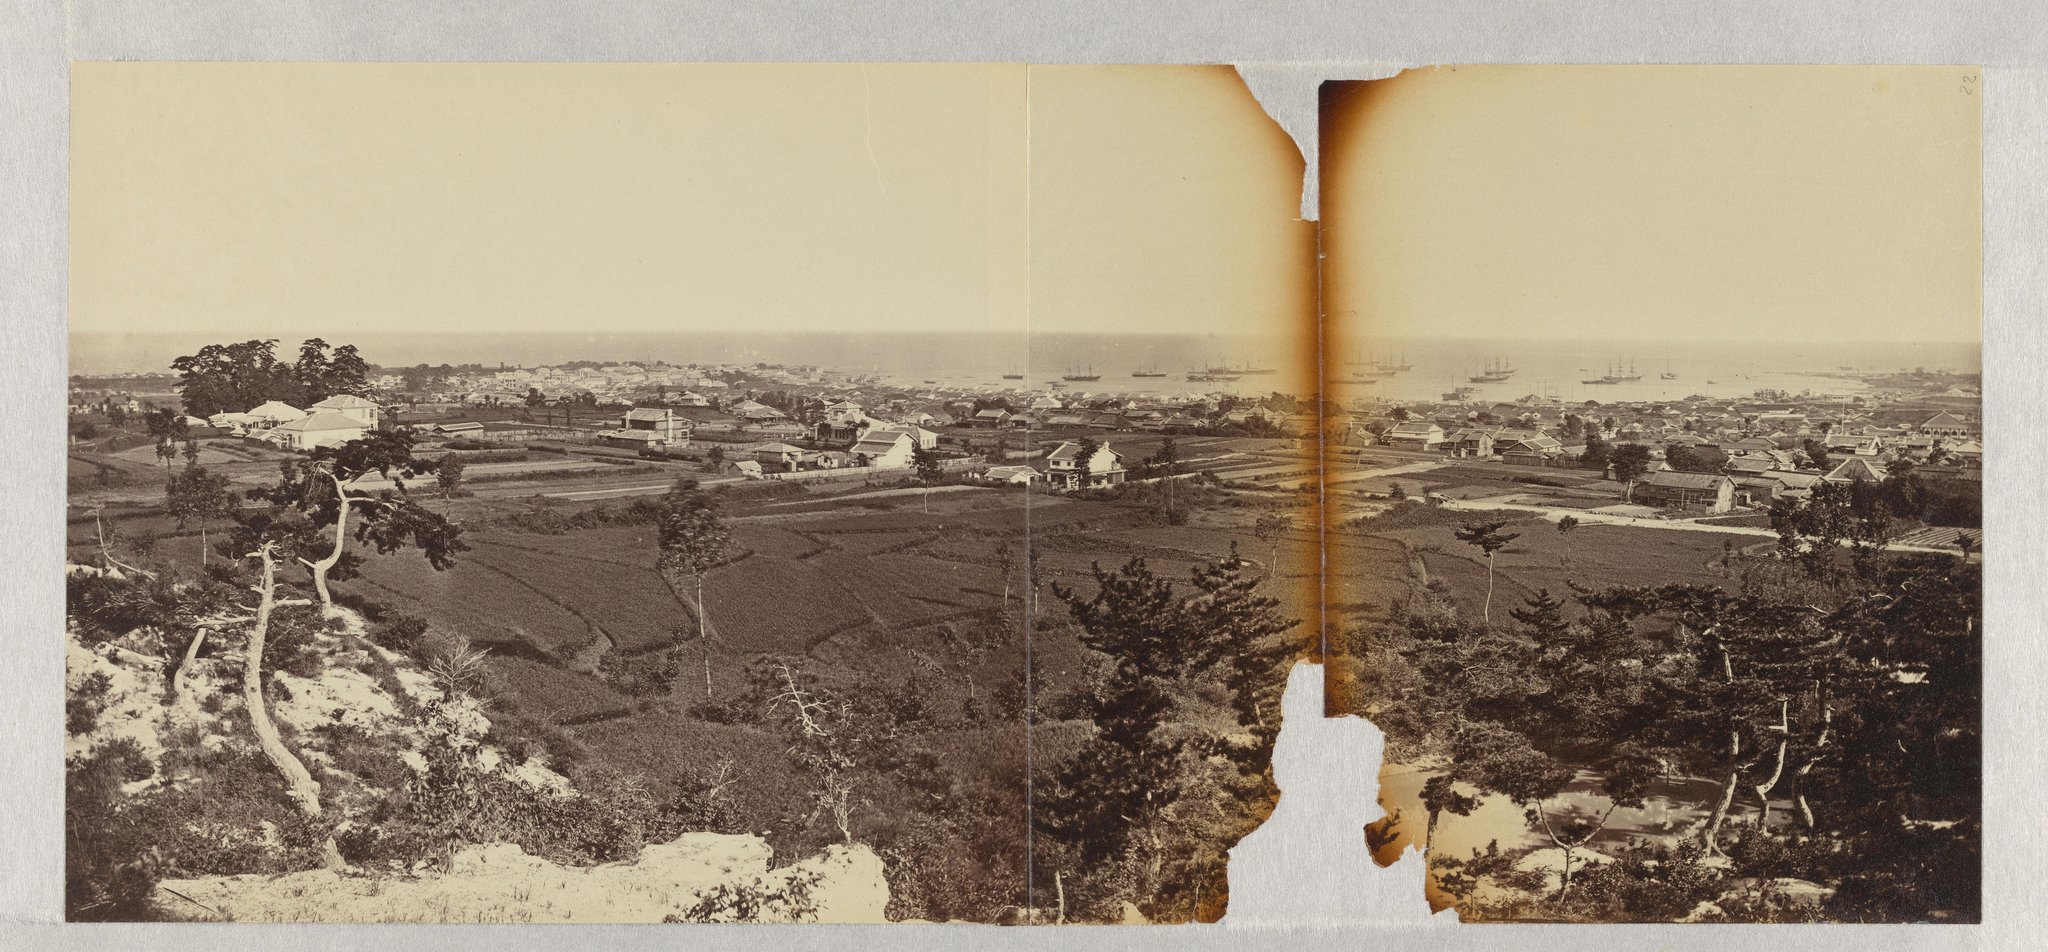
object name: photograph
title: Gezicht over Kobe (?), panorama bestaande uit 3 foto's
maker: Anonymous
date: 1865-1875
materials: paper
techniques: albumen print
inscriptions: number, inscription: ‘H5’, number: ‘27’